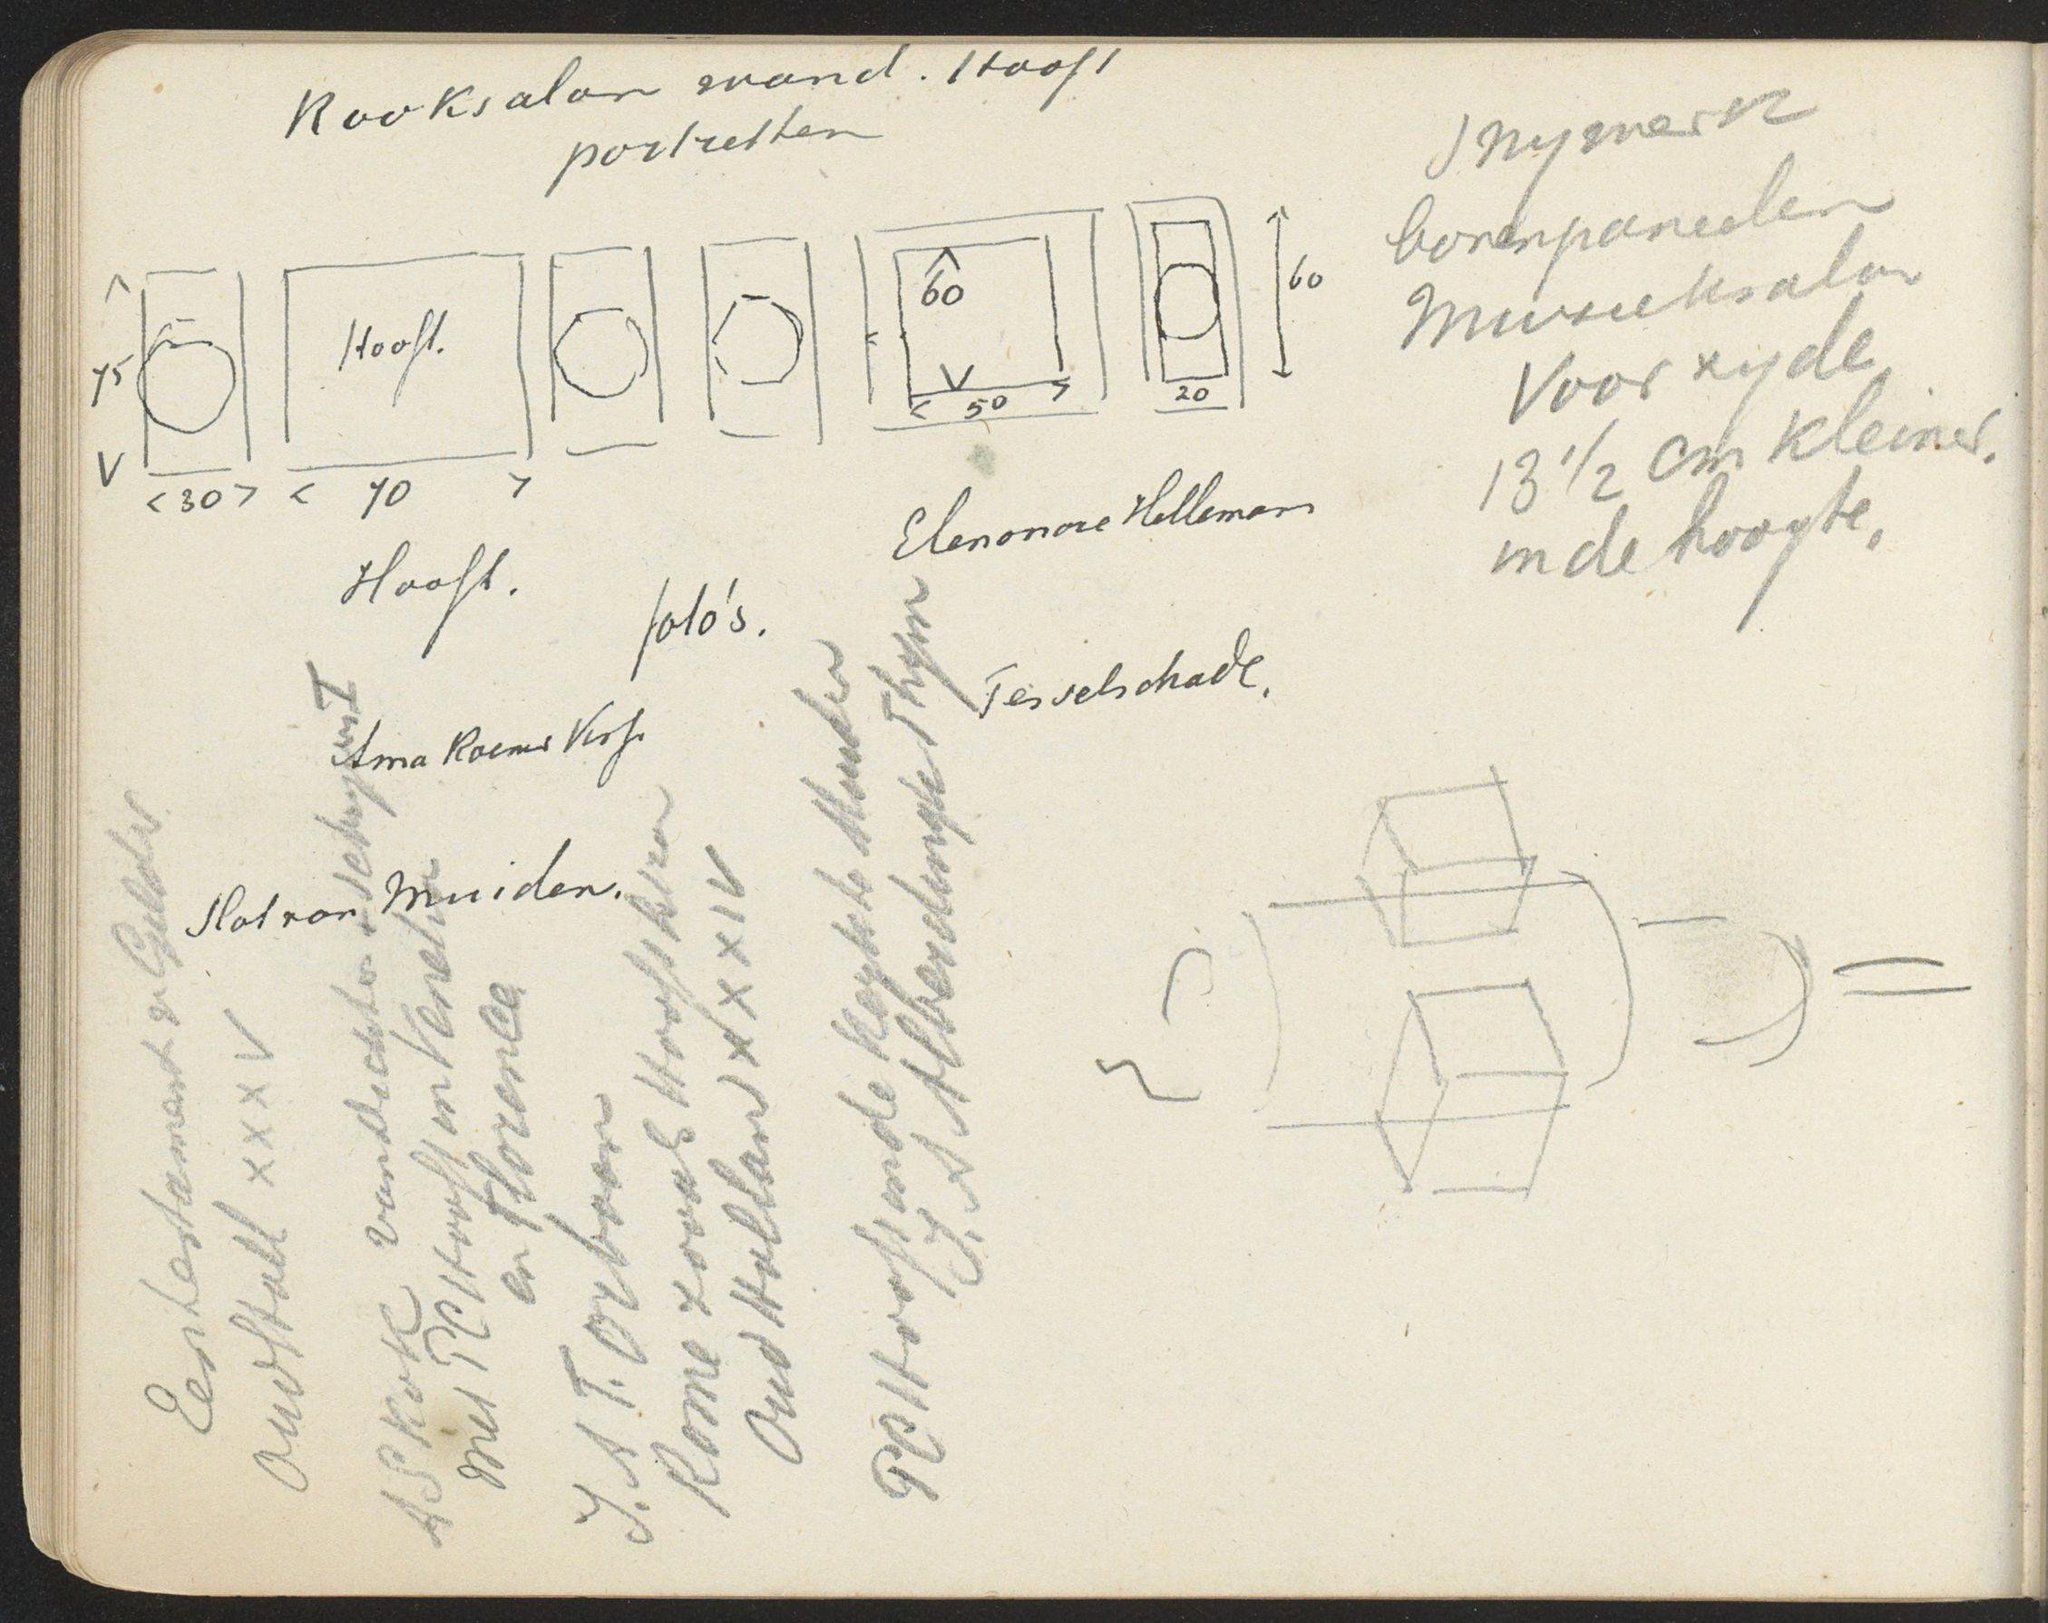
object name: sketchbook leaf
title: Ontwerp voor wandportretten in de rooksalon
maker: carel adolph lion cachet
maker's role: draughtsman, print maker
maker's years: 1864-1945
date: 1928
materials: ink, paper, pencil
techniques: pen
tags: architectural design or model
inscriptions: annotation: ‘Rooksalon wand Hoofd/ portretten/ [...]’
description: Blad 17 verso uit een schetsboek met 24 bladen.